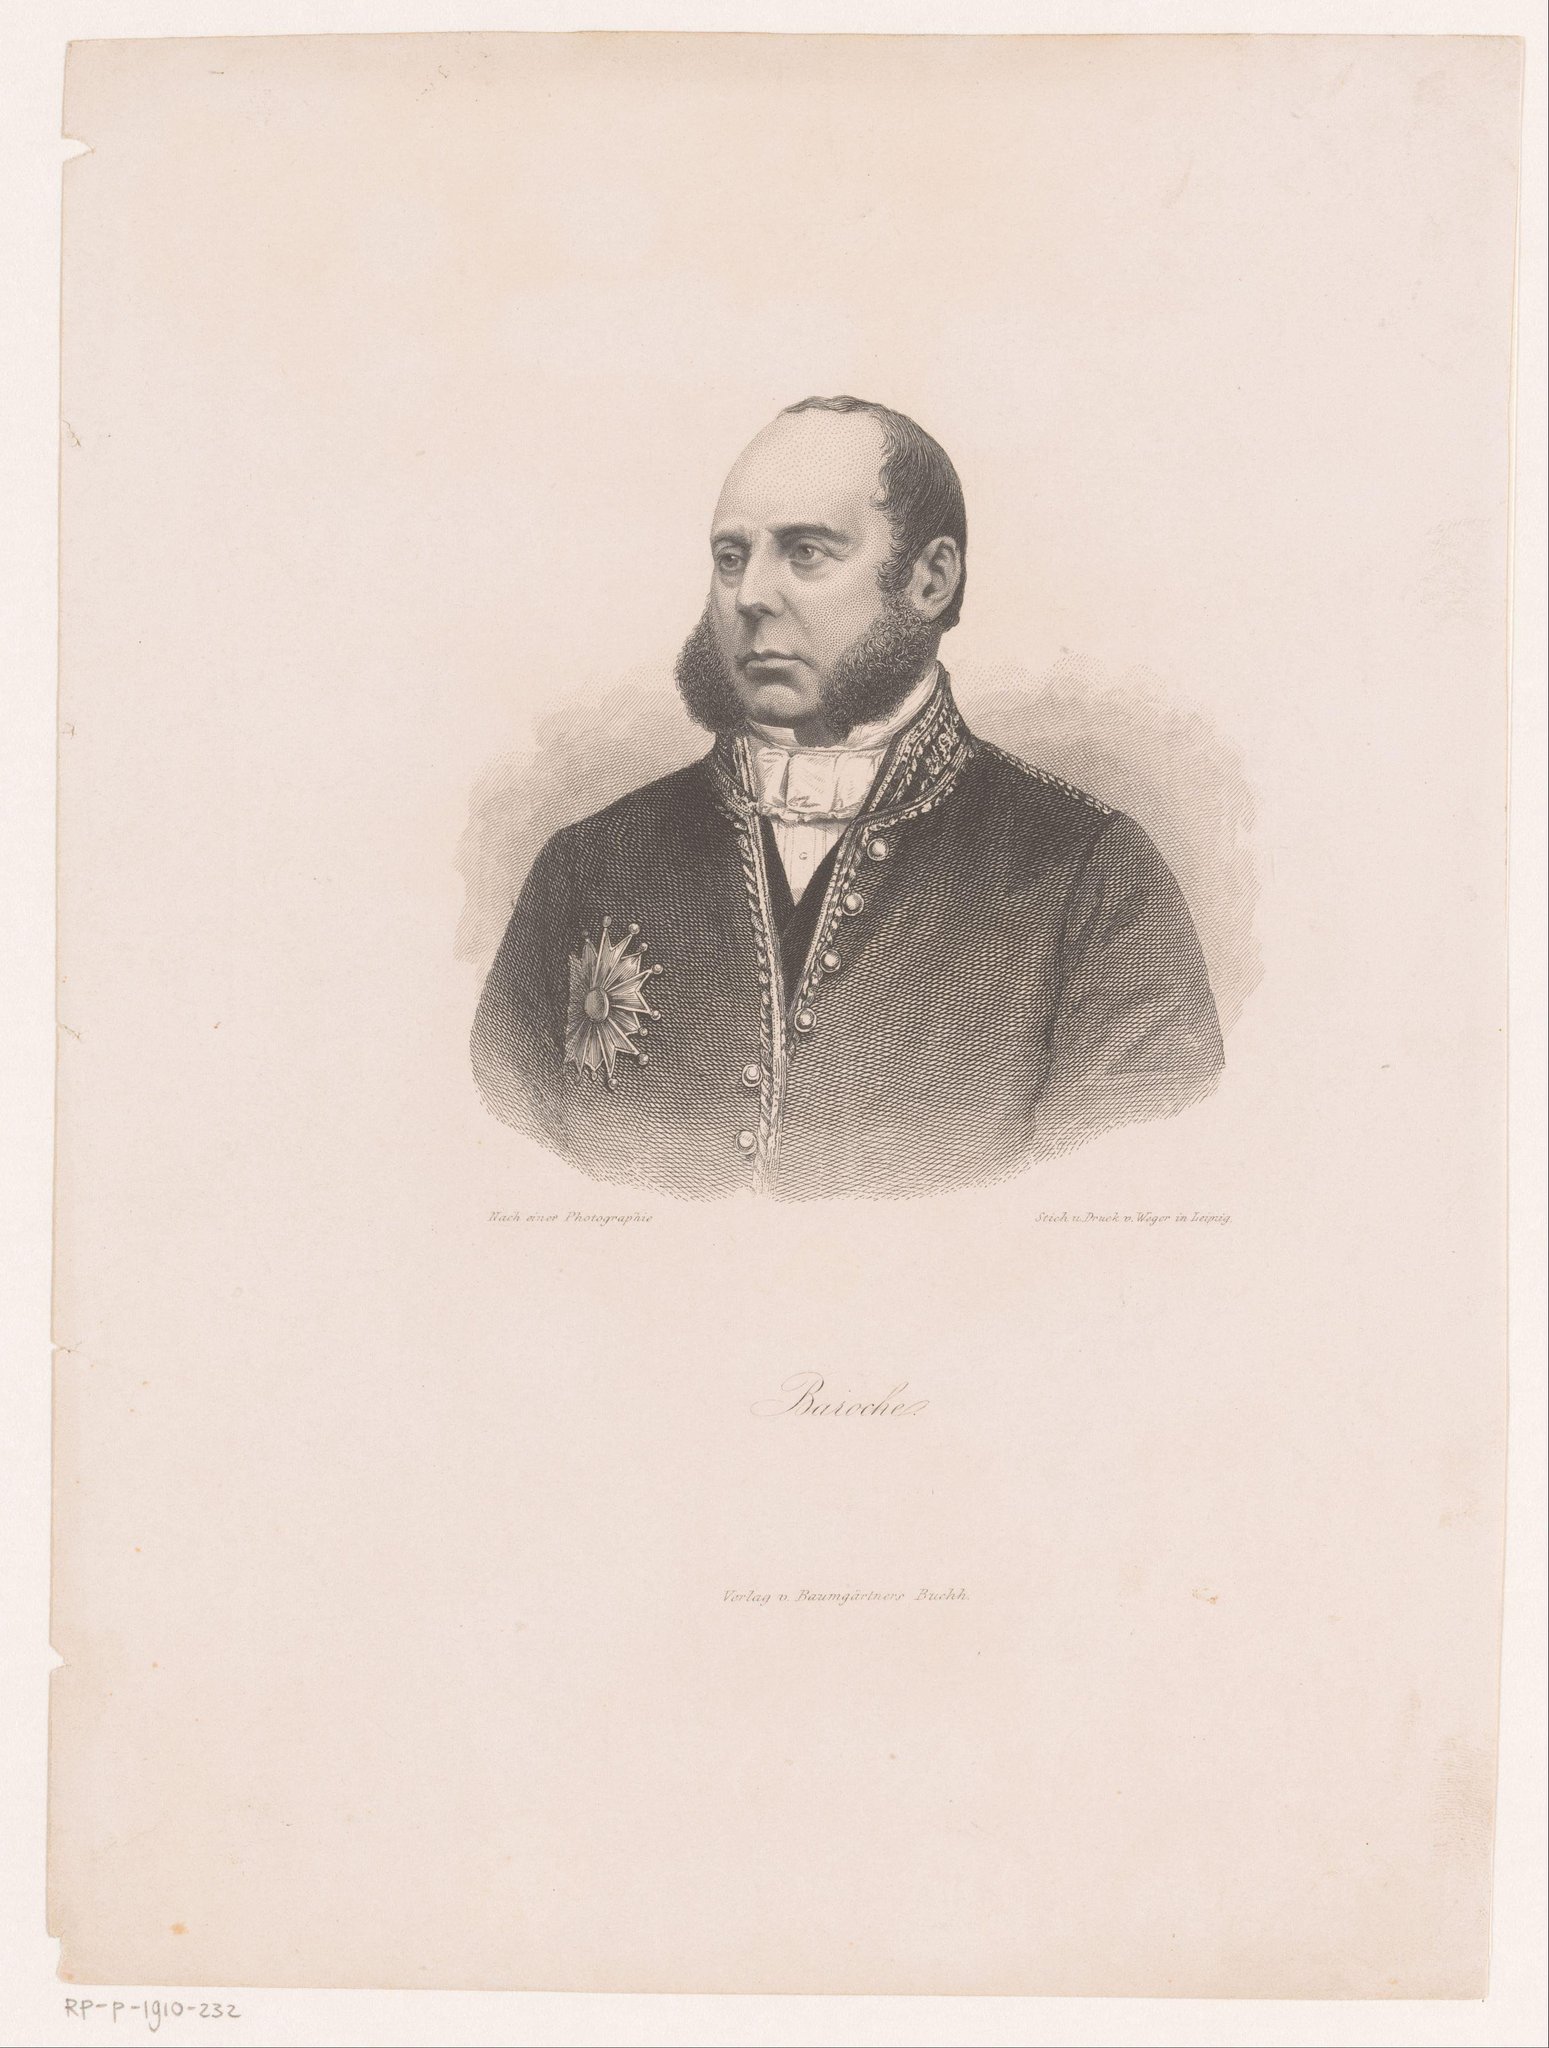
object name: print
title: Portret van Pierre Jules Baroche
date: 1849-1892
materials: paper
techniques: engraving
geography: leipzig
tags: politician, historical persons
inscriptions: collector's mark: Lugt 2228